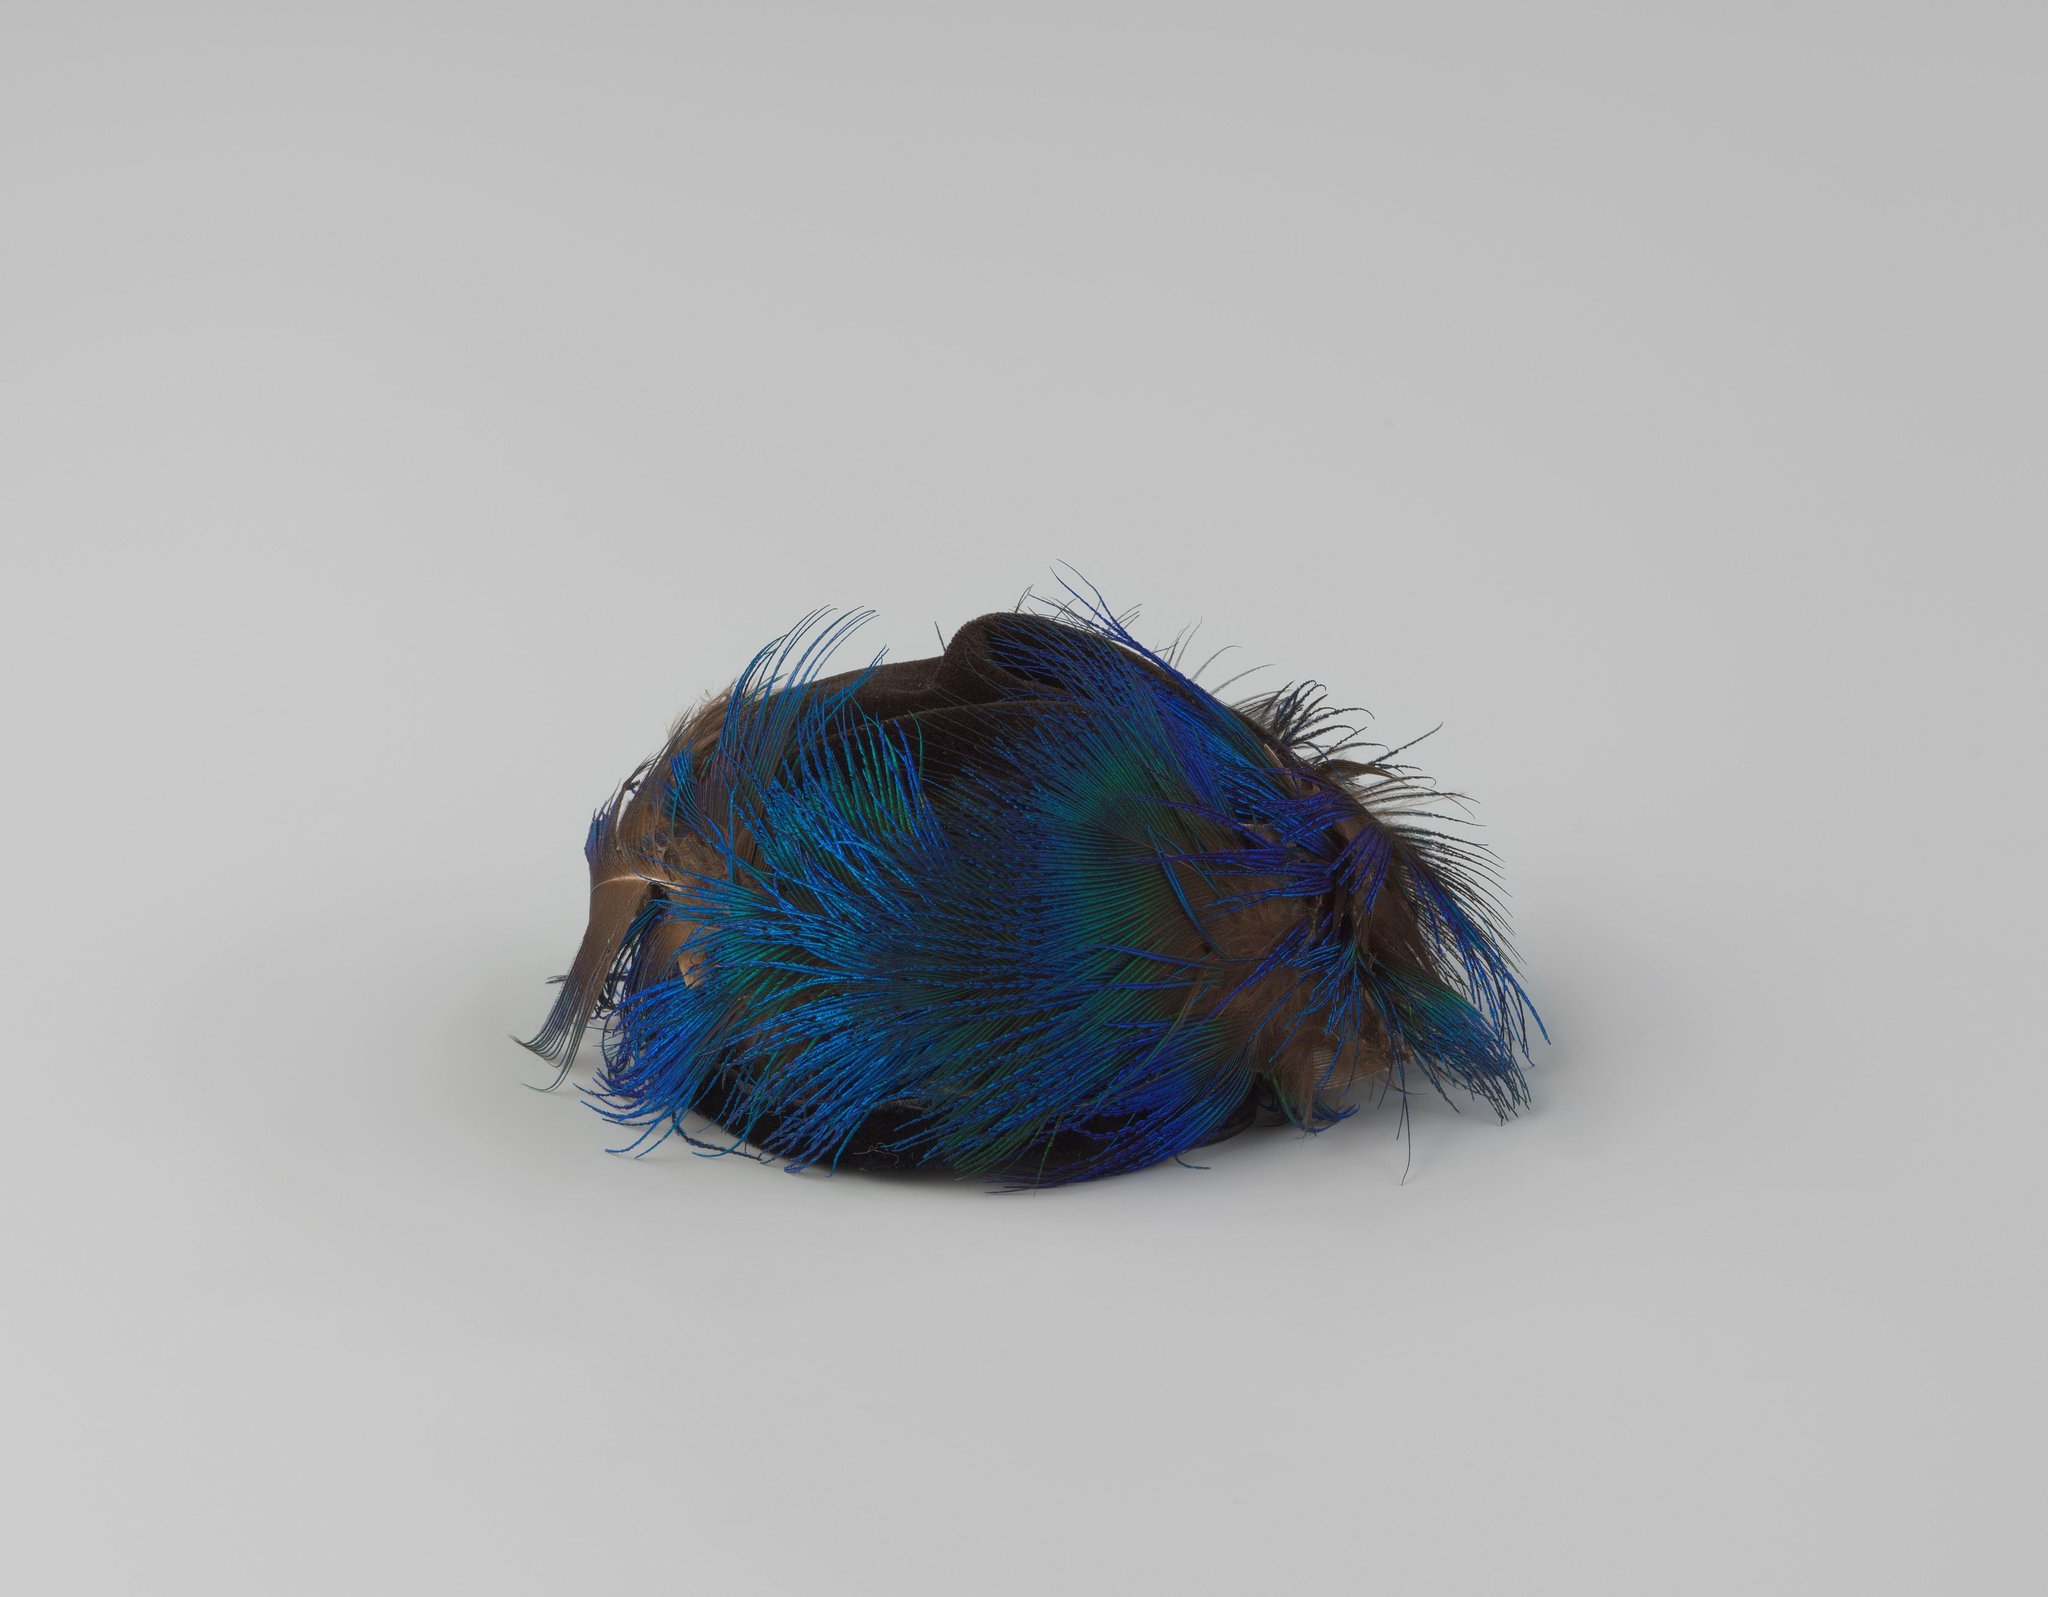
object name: hat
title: Hoed met blauwe veren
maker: Anonymous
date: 1870-1880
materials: velvet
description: Hoed met blauwe veren. Behorende bij pop 15444.